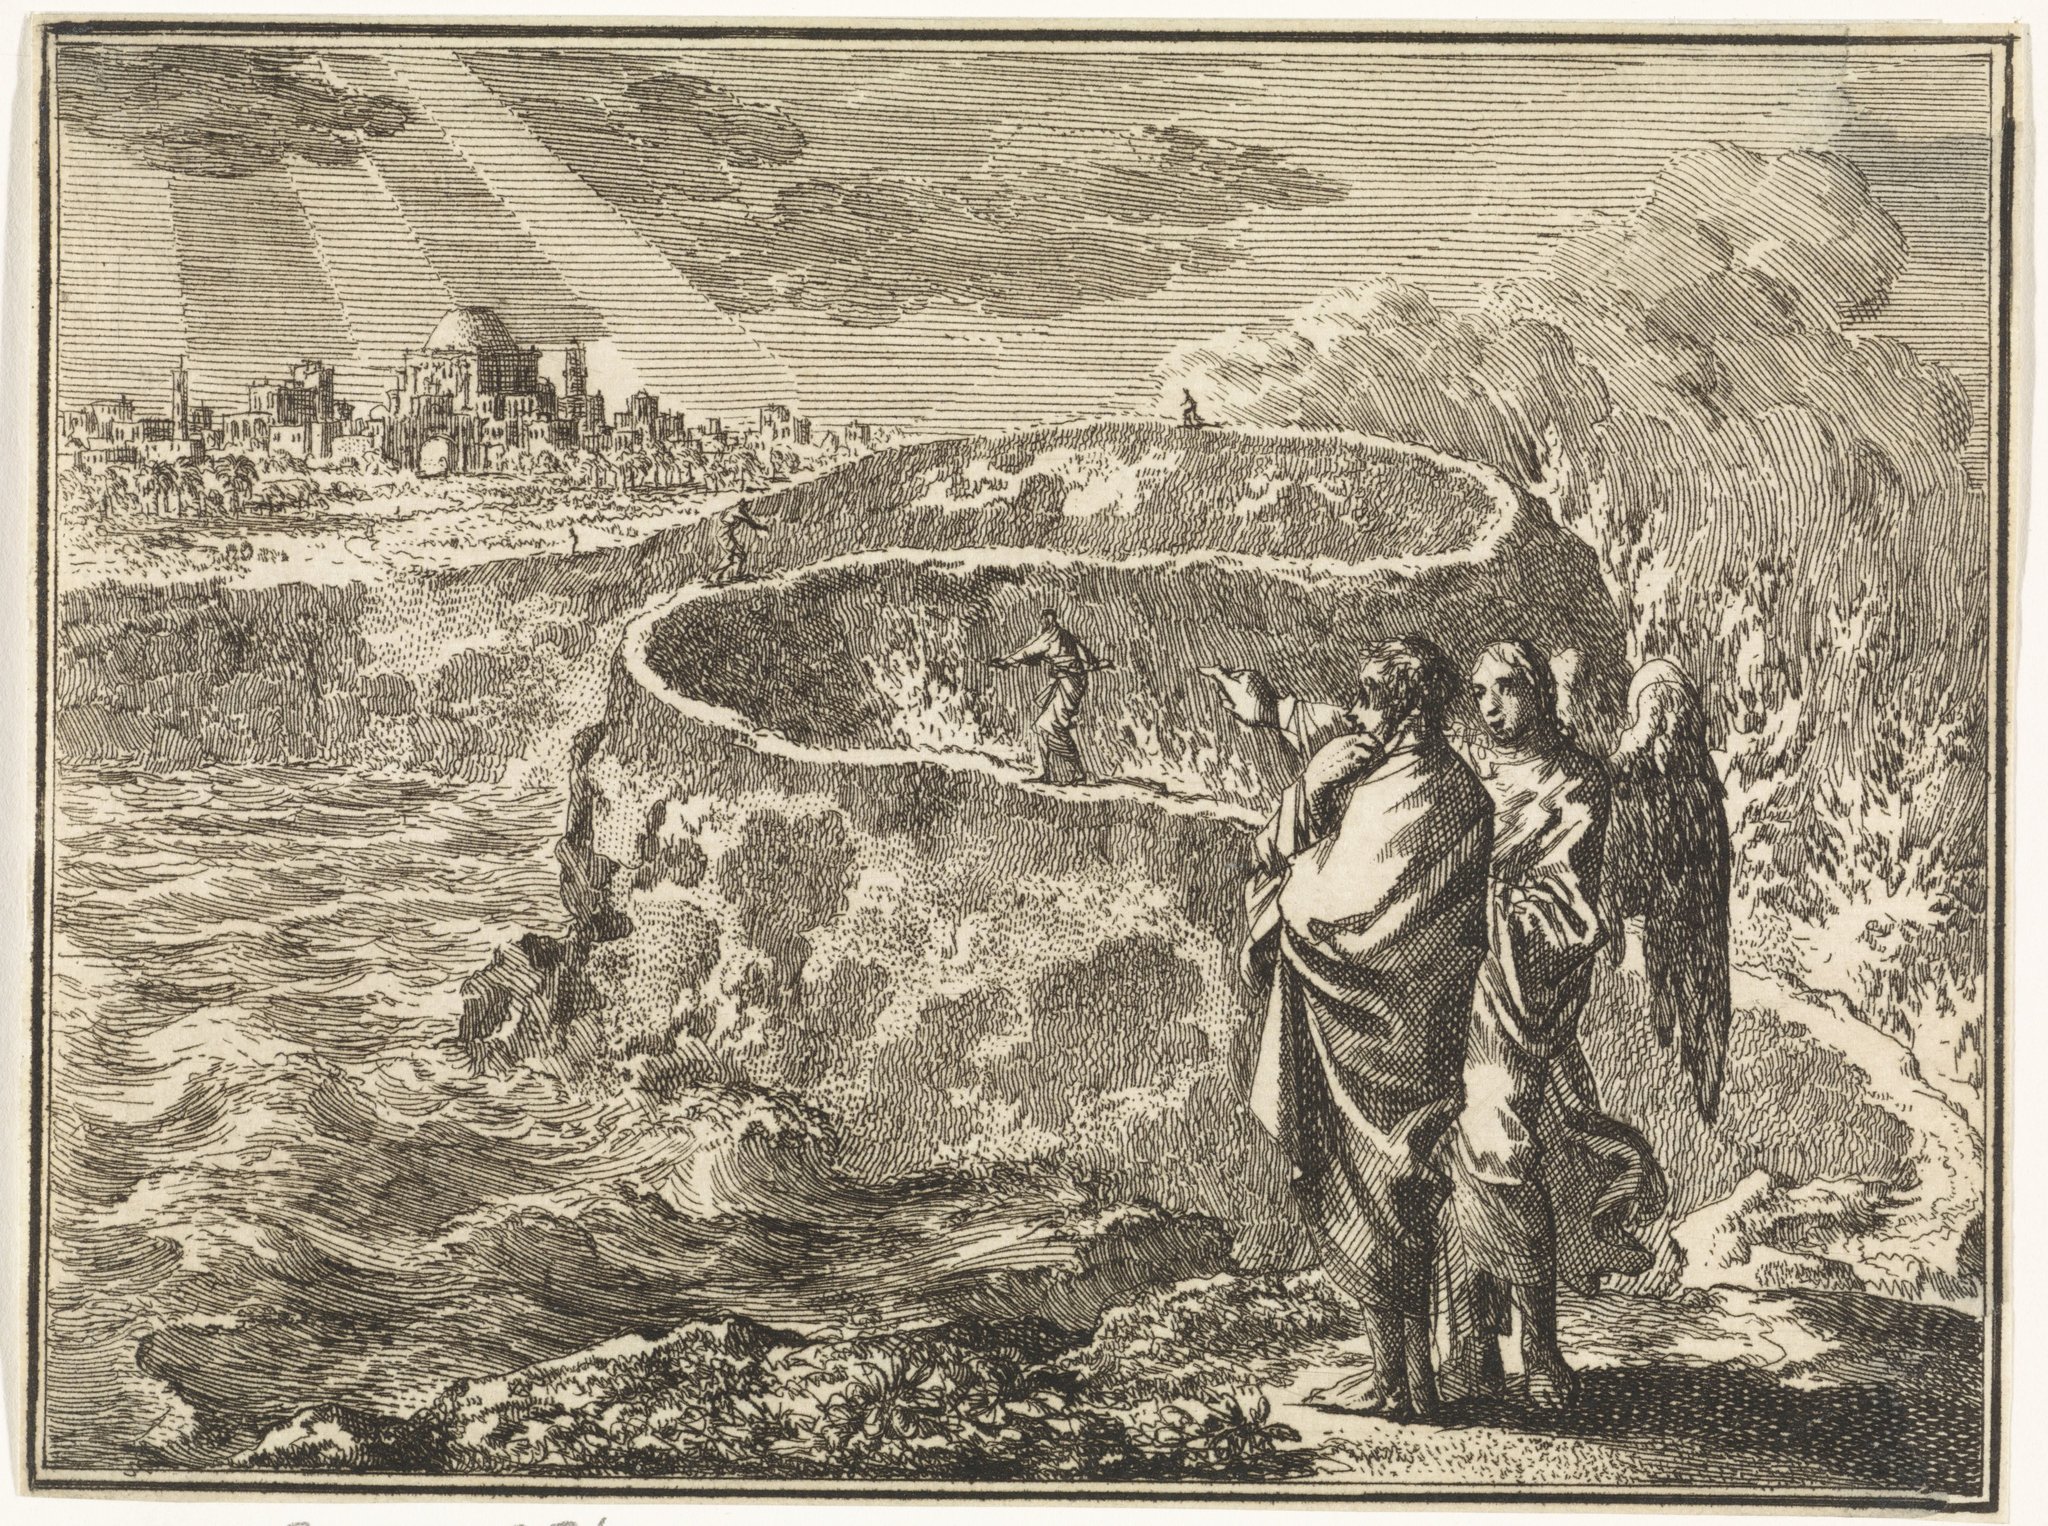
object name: print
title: Een engel wijst naar een wandelaar op de smalle weg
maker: jan luyken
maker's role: draughtsman, print maker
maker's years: 1649-1712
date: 1712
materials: paper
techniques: etching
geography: amsterdam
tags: the way to destruction is broad and the gate is wide; the way to life is narrow and the gate is straight ~ doctrine of christ on love, etc. (matthew 7:13-14; luke 13:24)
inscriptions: number: ‘182’, collector's mark: Lugt 2228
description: Illustratie uit: Luyken, Jan. De schriftuurlyke geschiedenissen en gelykenissen van het Oude en Nieuwe Verbond, 2 delen. Amsterdam: Wed. Pieter Arentsz II en Cornelis van der Sys, 1712, dl. I.